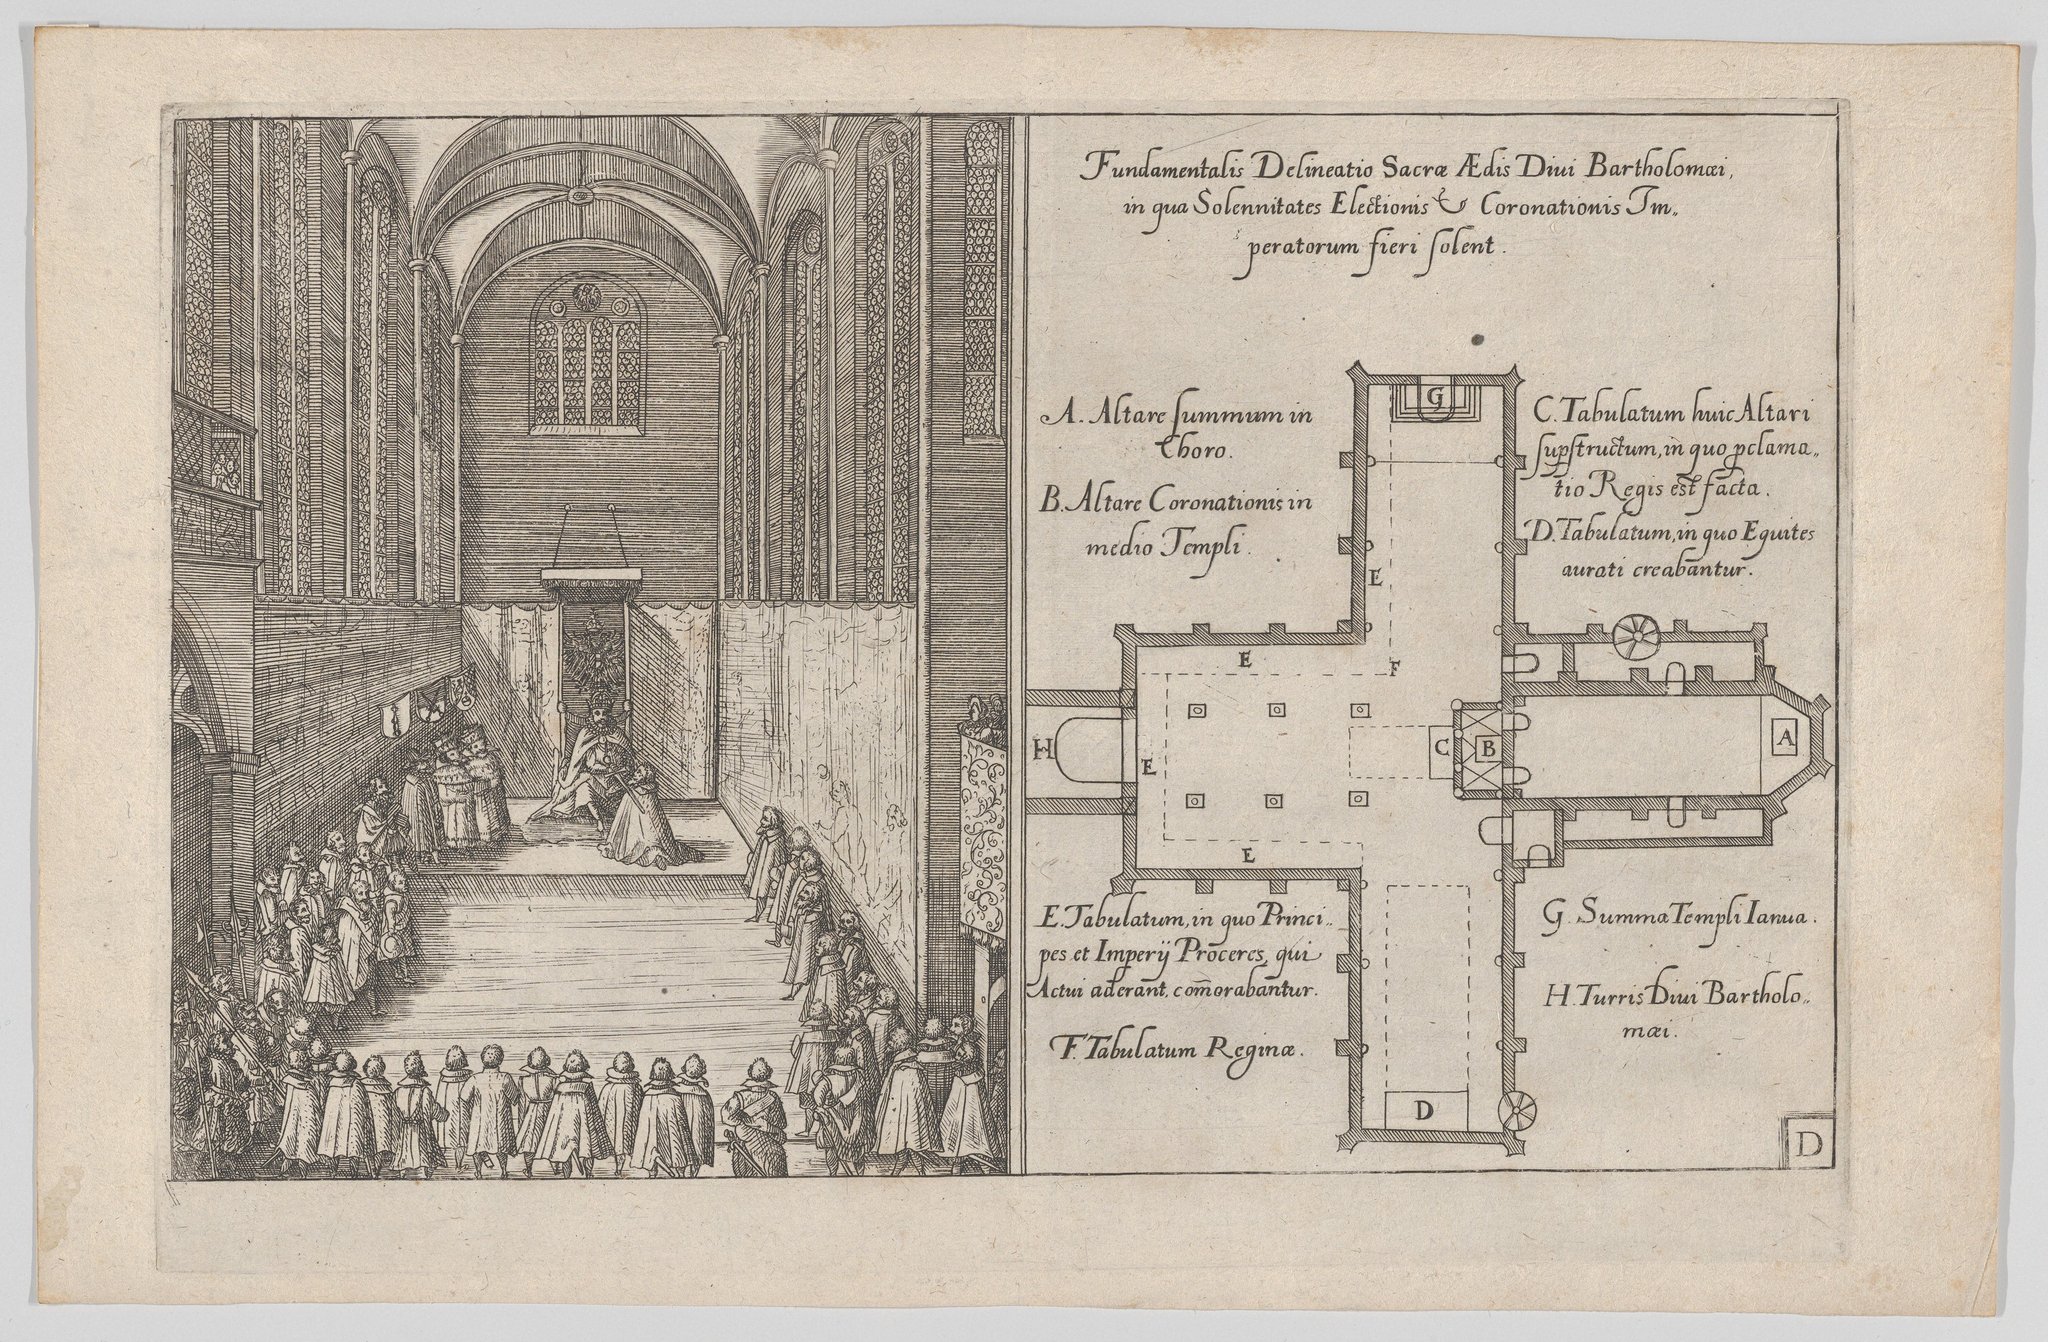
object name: print, fete, ornament architecture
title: Plate D: Election and Coronation of Emperor Maximilian II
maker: anonymous, german, 17th century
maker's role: publisher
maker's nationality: german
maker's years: 1600-1700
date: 1612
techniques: etching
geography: frankfurt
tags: elections,kings,crowd